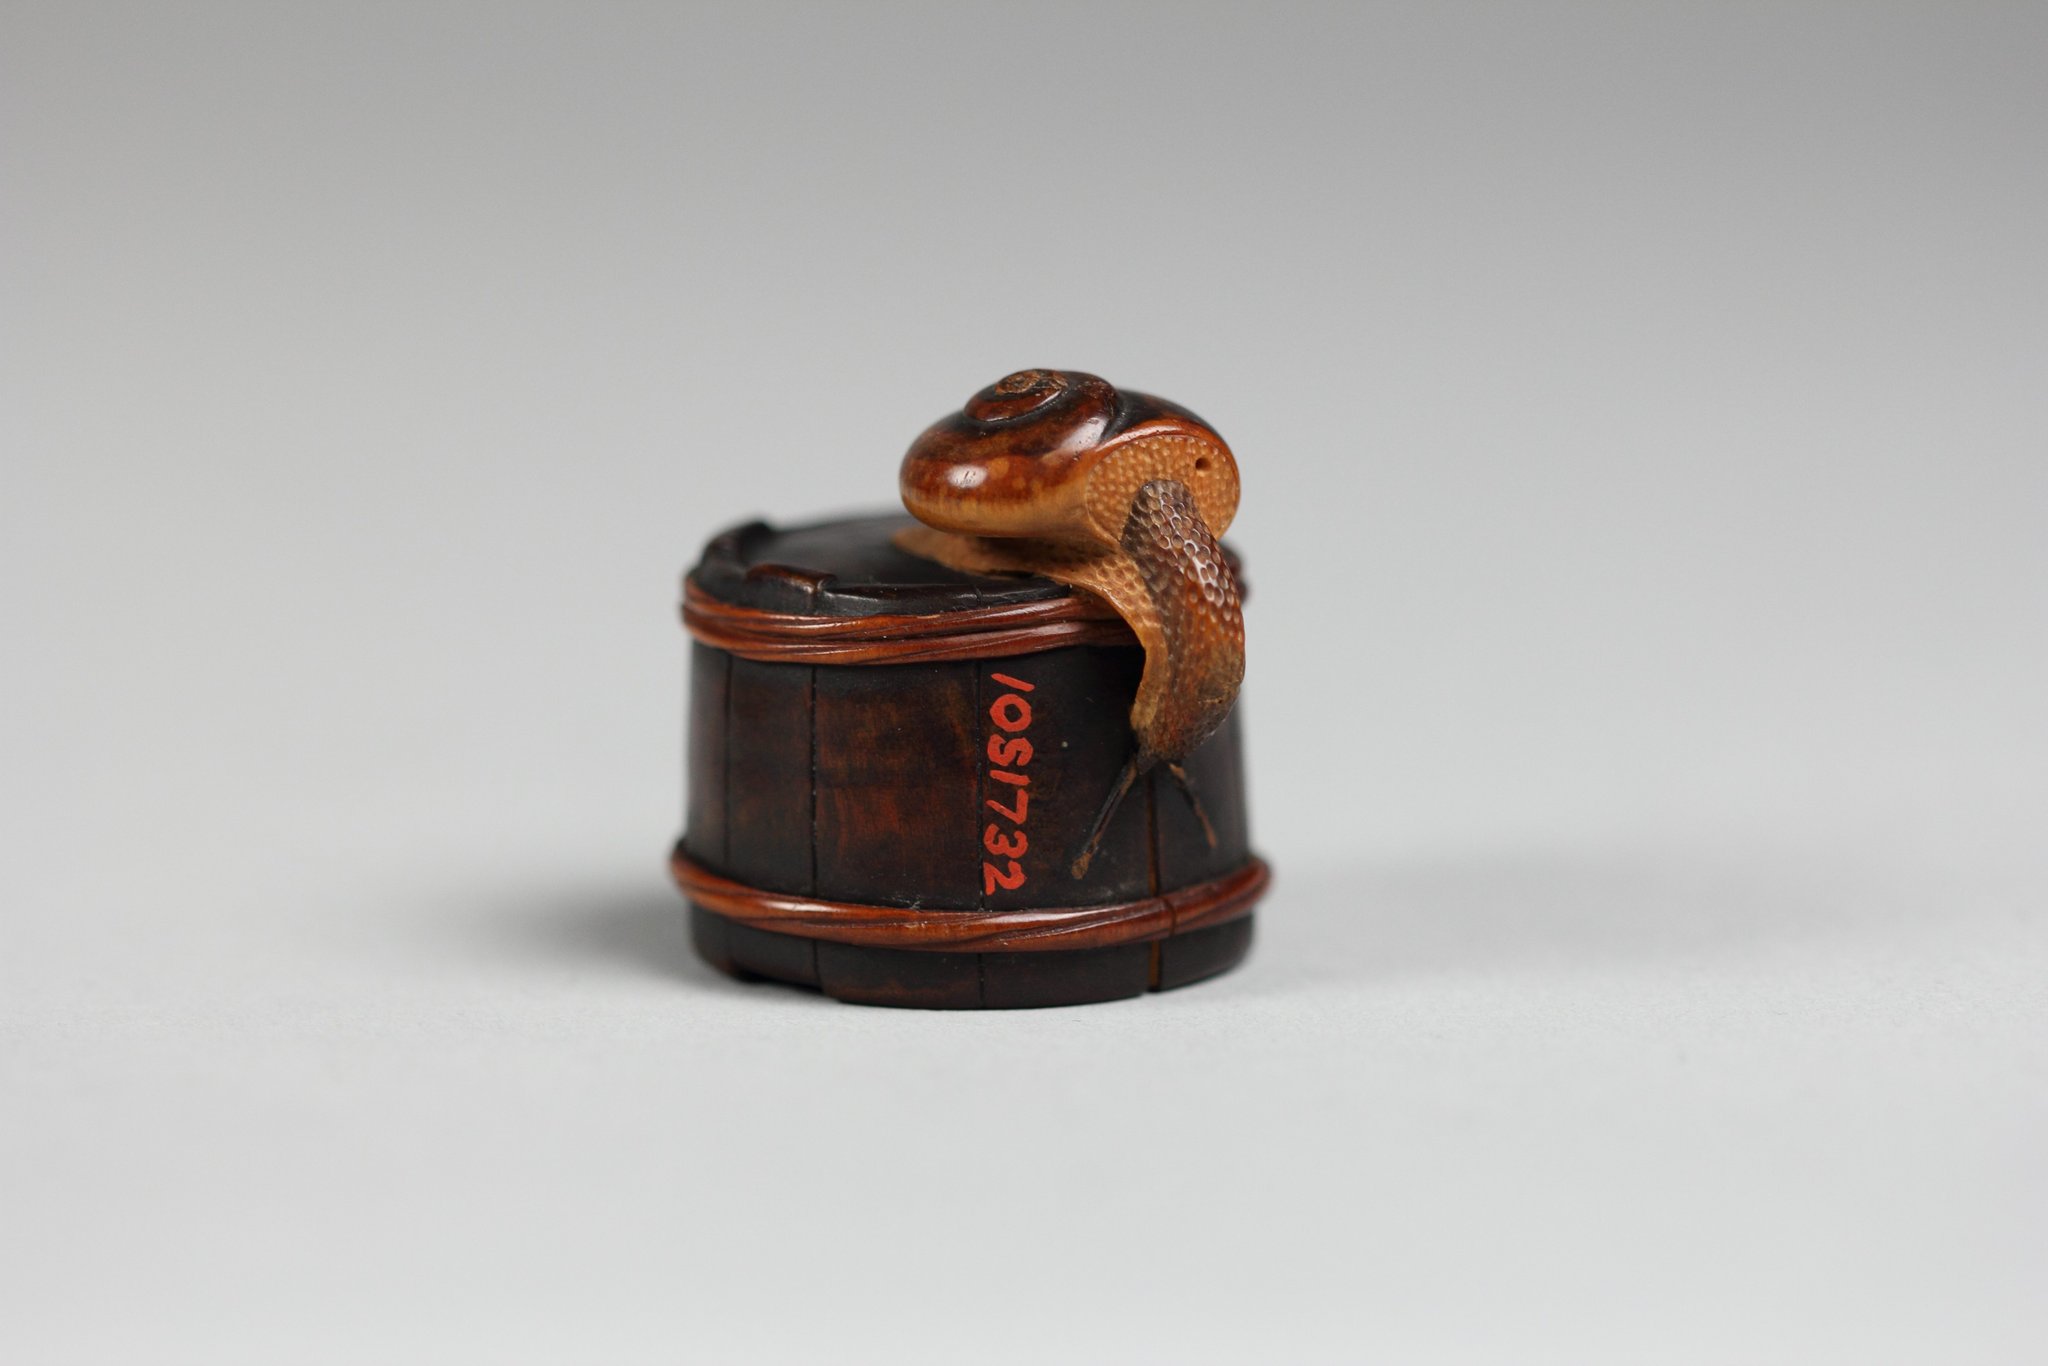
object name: netsuke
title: Netsuke of Snail on a Box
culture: japanese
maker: shigemasa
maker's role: artist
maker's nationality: japanese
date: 1801-1900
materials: wood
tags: snails